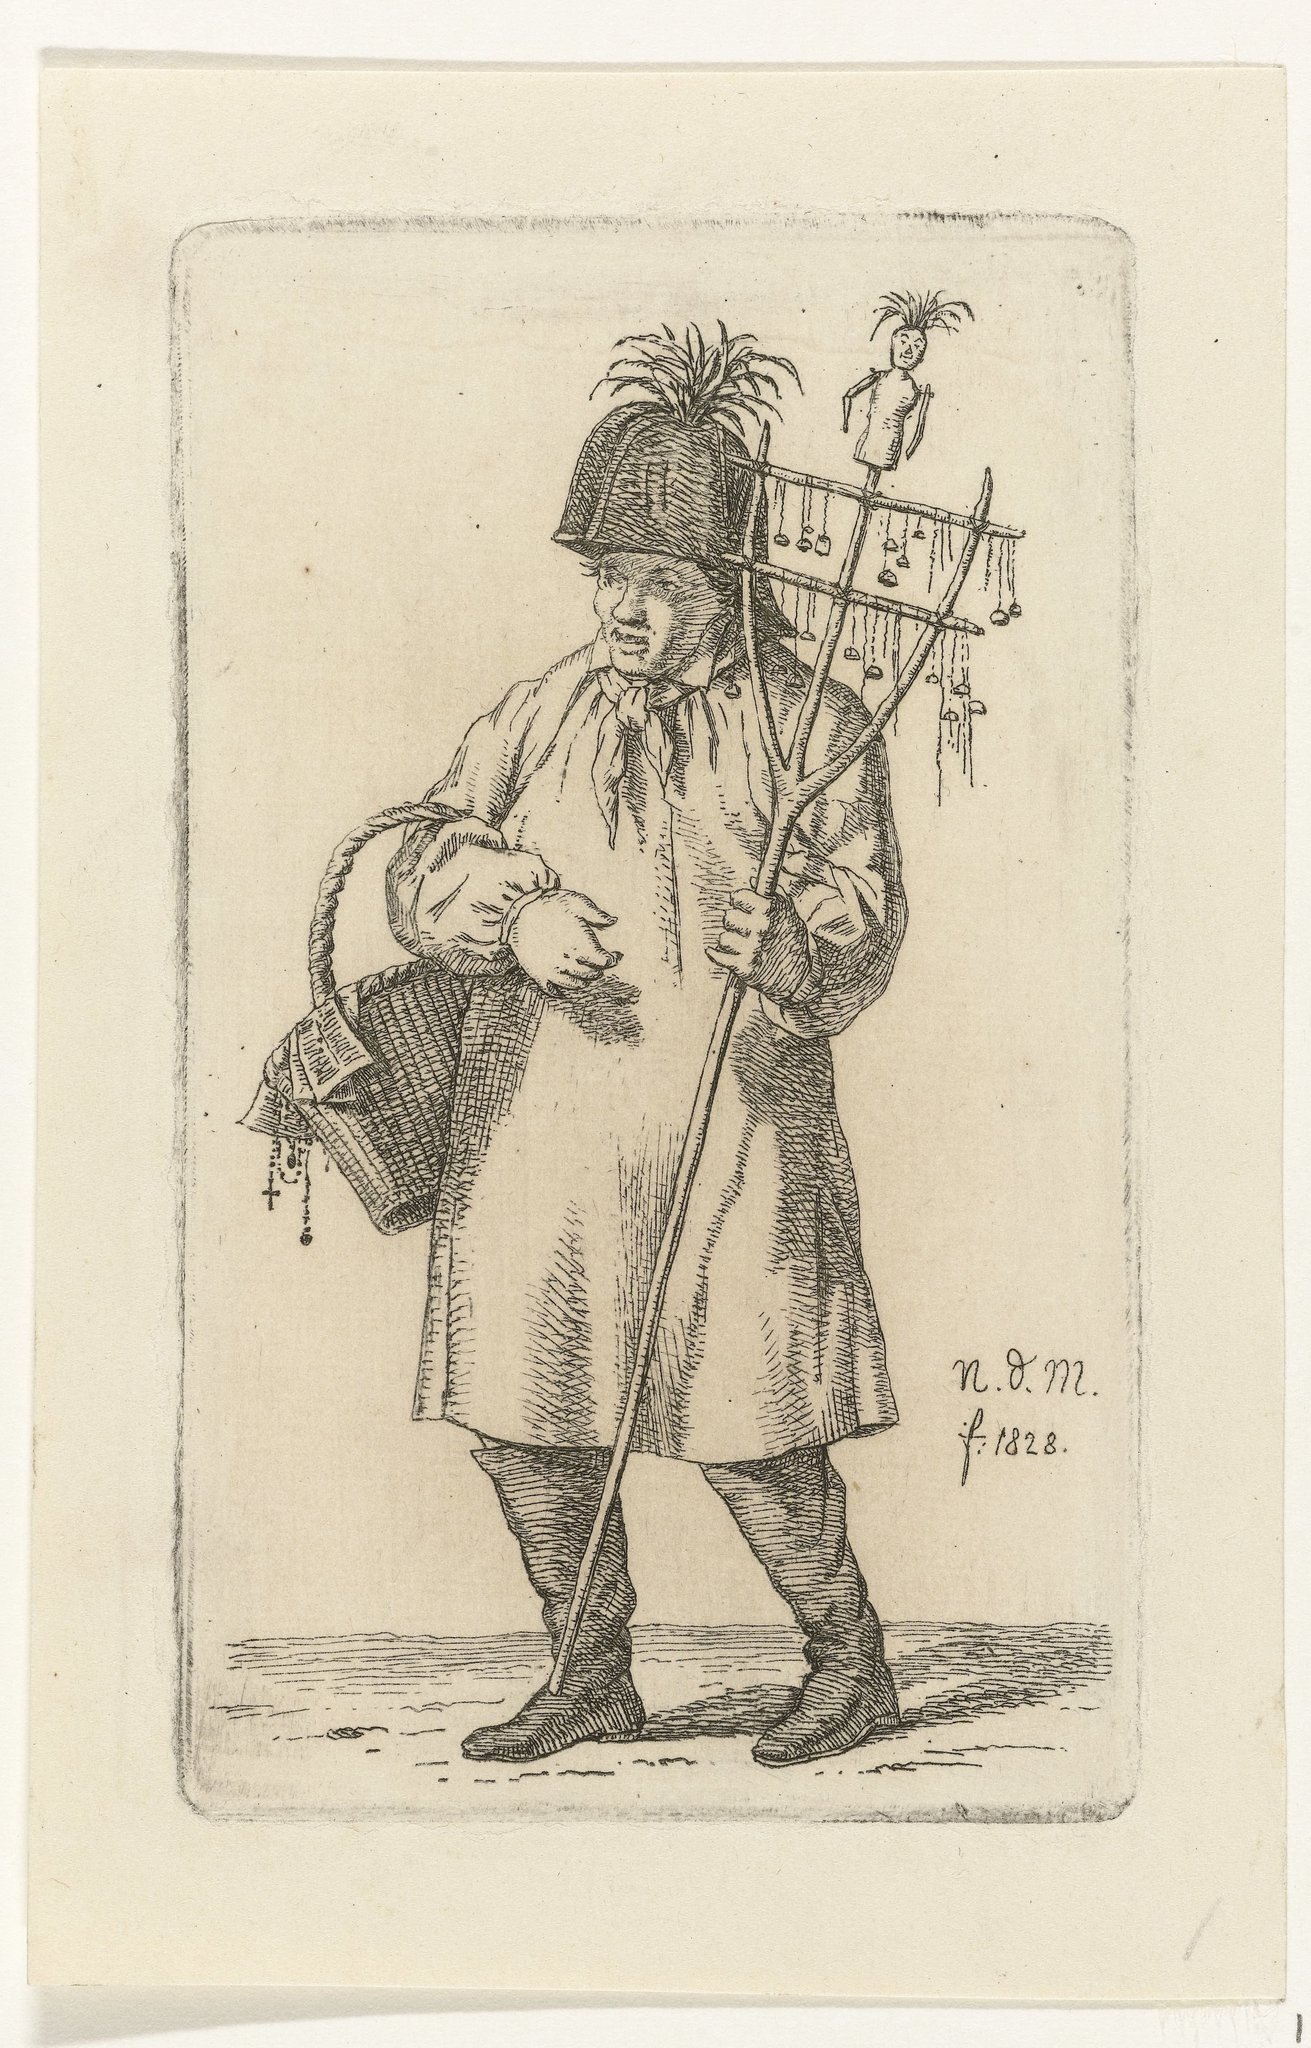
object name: print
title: 12 Studie-beeldjes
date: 1828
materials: paper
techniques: etching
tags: street-trader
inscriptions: collector's mark: Lugt 2228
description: Straatverkoper met een stok met koopwaar en een mand. Prent uit een serie van twaalf prenten met studies van menselijke figuren.